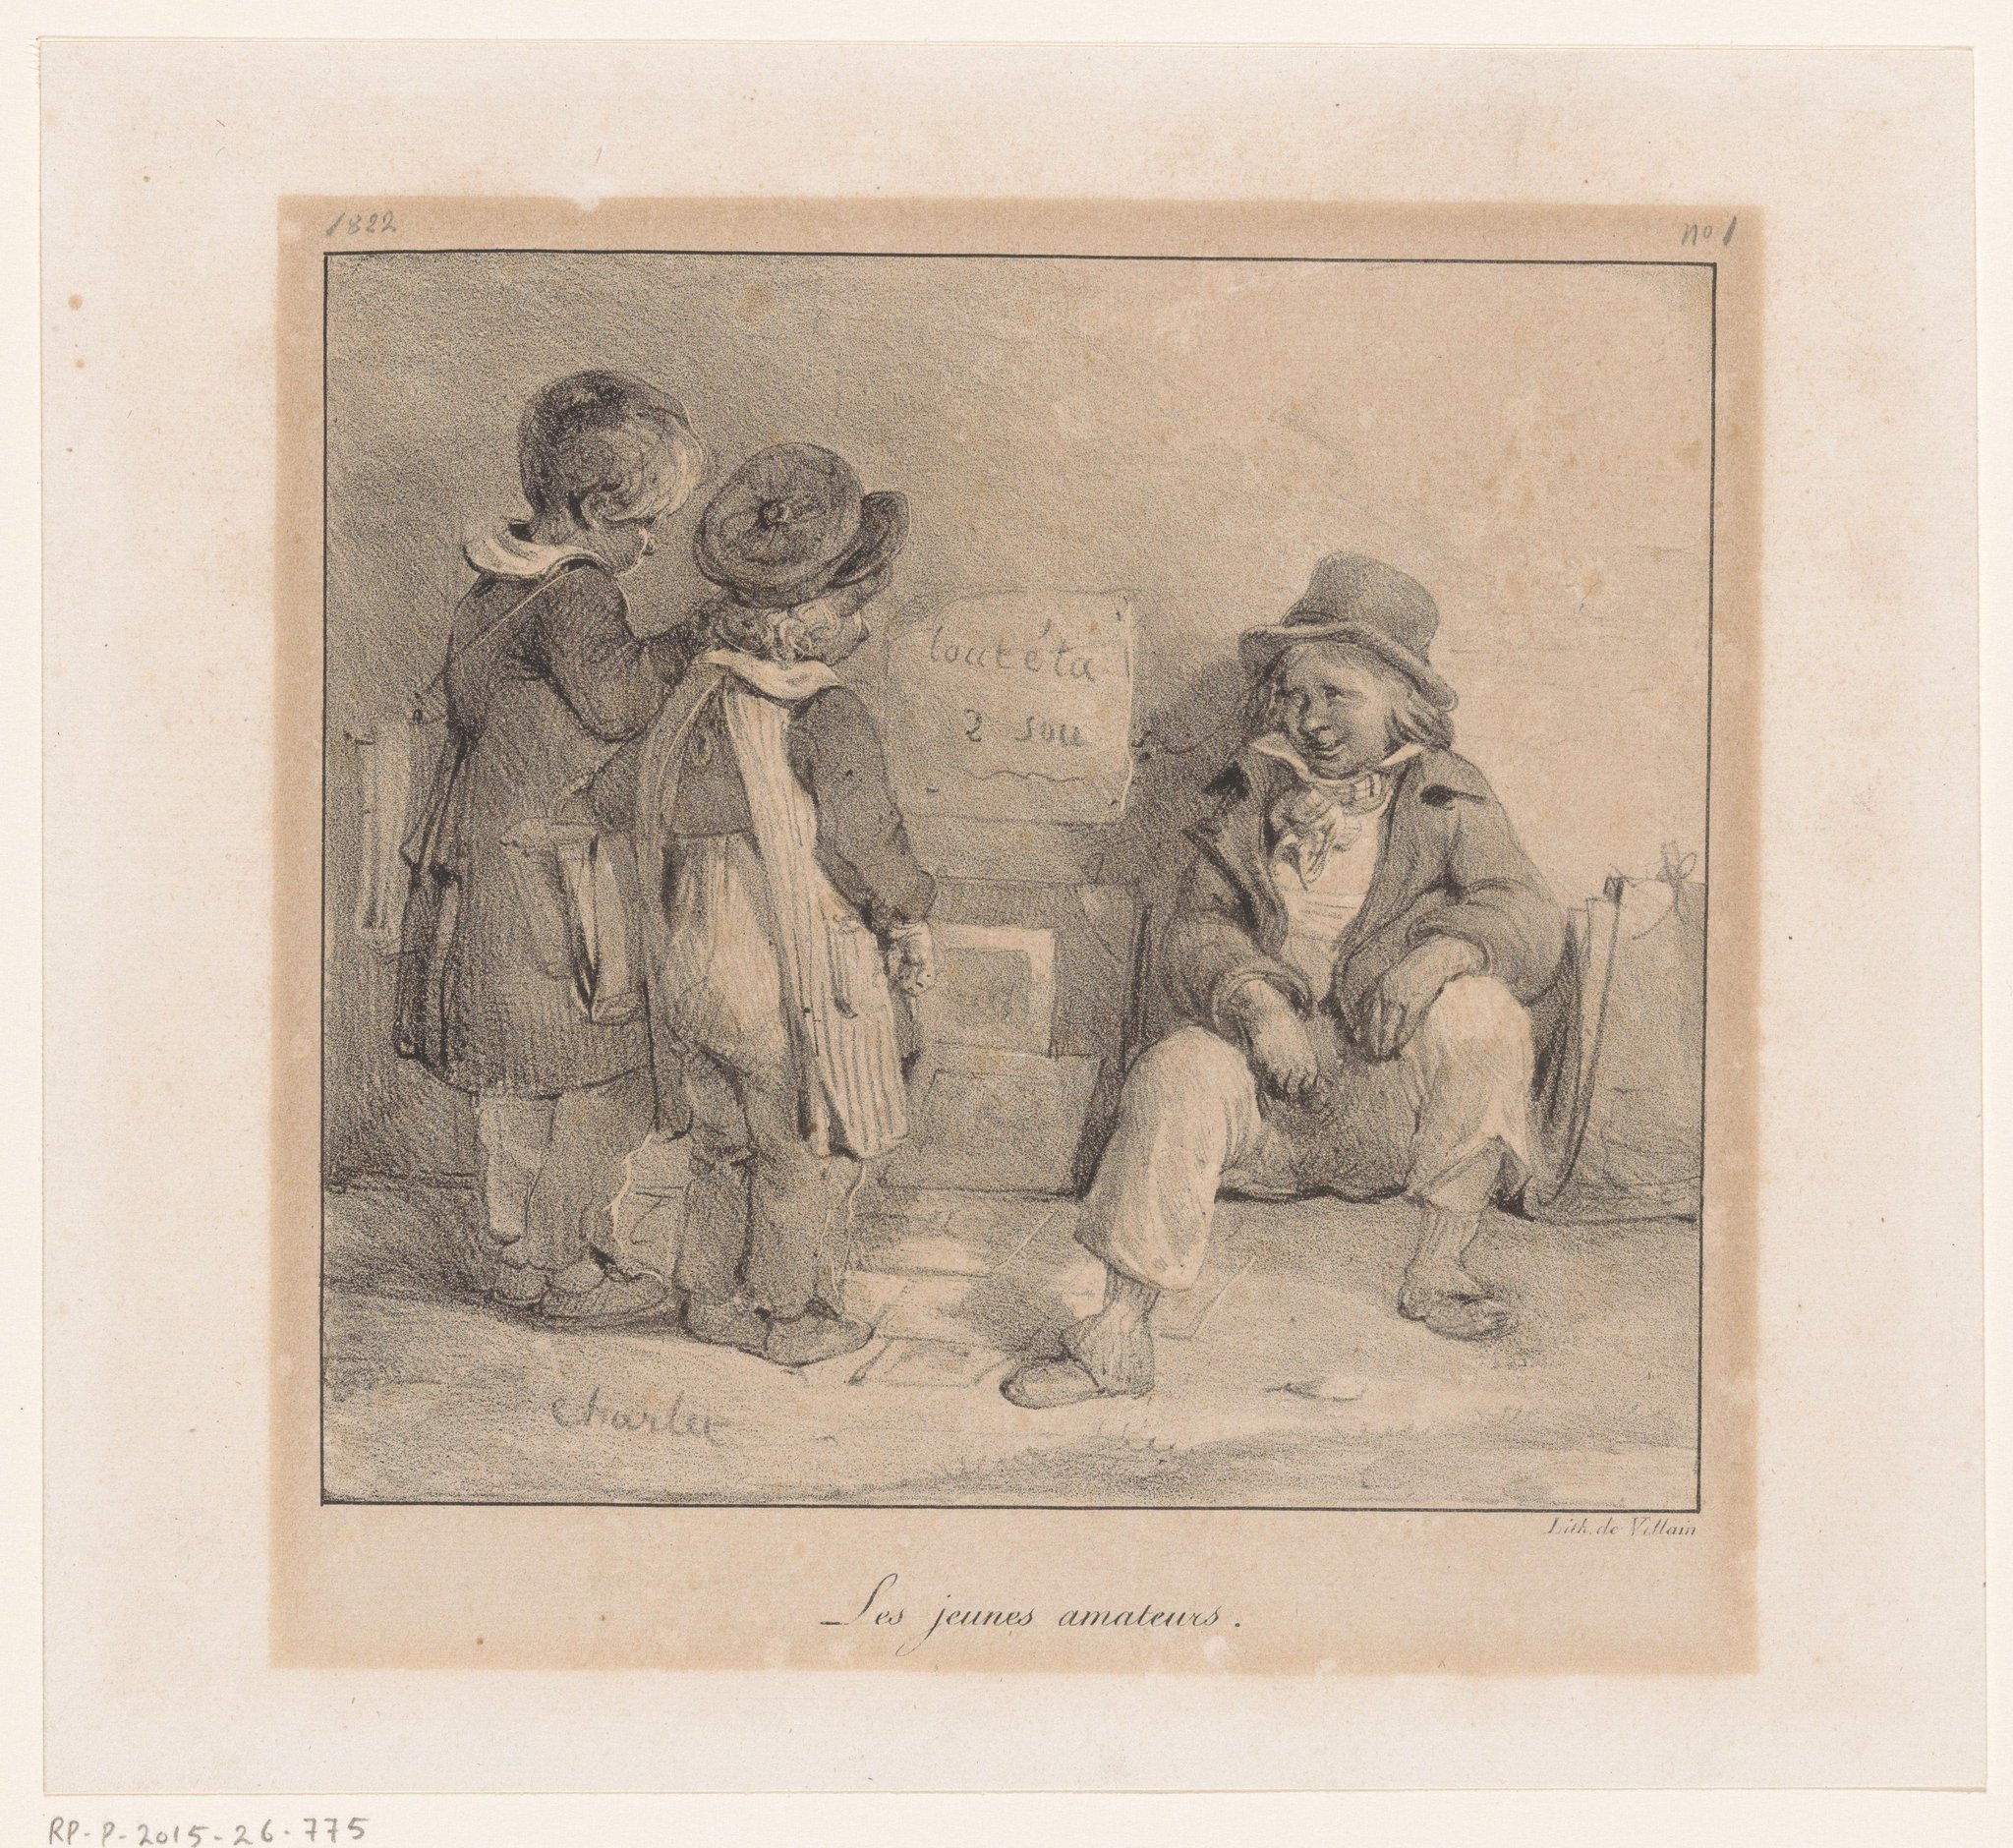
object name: print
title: Recueil de Croquis à l'usage des petits enfants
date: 1822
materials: paper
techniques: lithograph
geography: paris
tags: print, e.g.: engraving, etching, lithograph, child, street-trader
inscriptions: annotation: ‘1822/ no. 1’, collector's mark: Lugt 2228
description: Een jongen en een meisje met schooltassen onder hun arm kijken naar een jonge prentverkoper die op de grond zit, zijn rug tegen de muur geleund. Naast hem staat zijn voorraad uitgesteld met een bordje: "tout éta 2 sou".